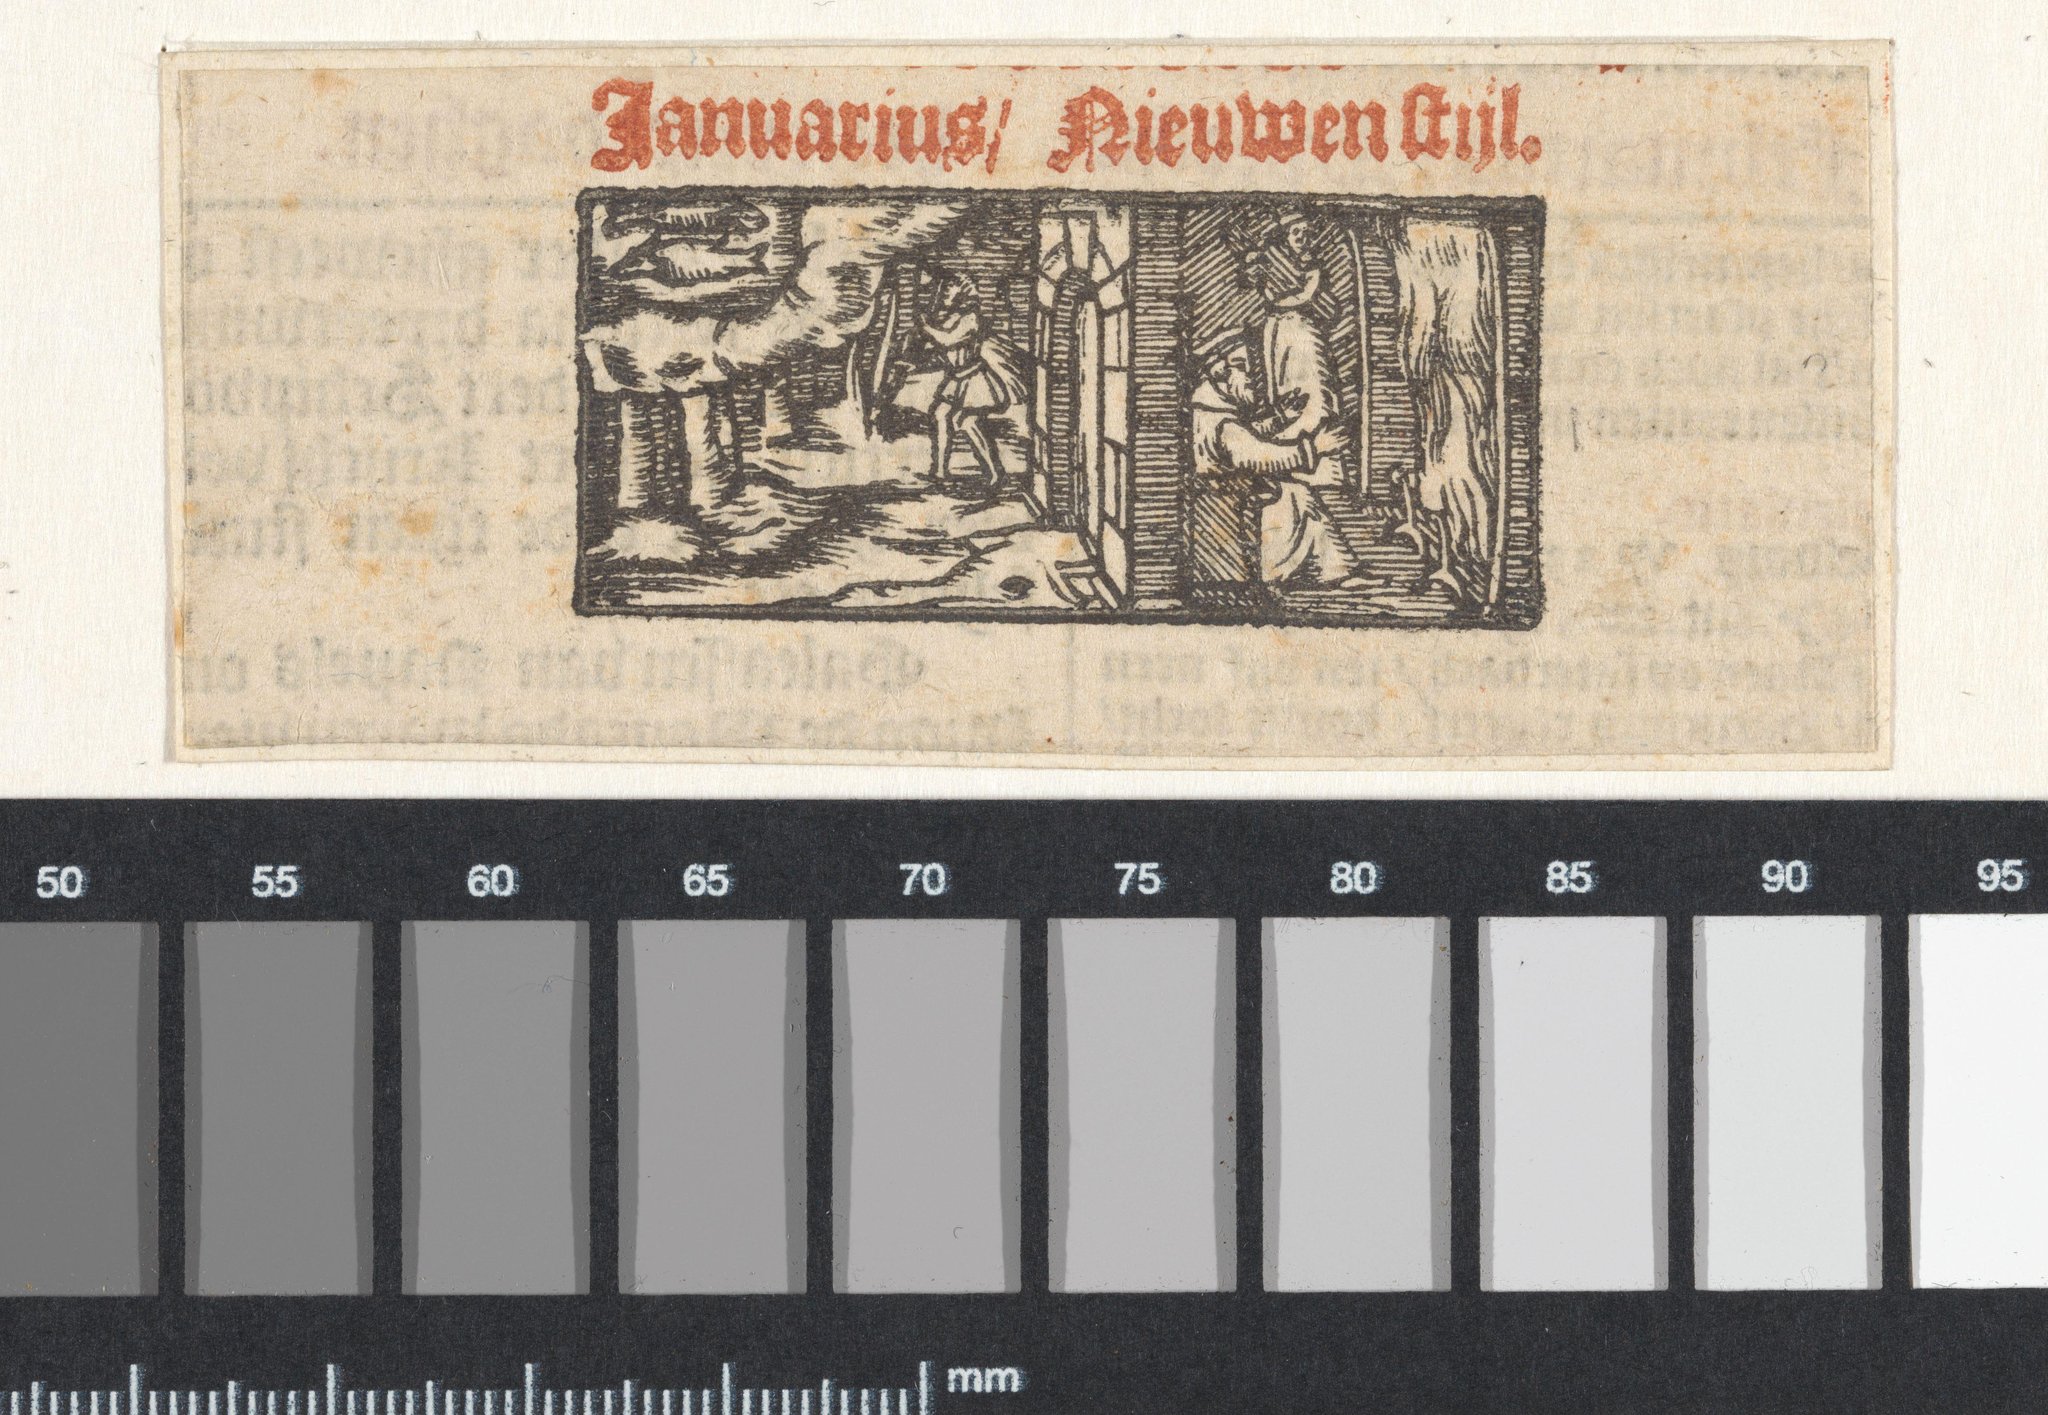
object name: print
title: Maanden van het jaar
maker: Anonymous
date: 1600-1699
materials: paper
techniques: letterpress printing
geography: netherlands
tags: open hearth, fire-place, snow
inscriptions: collector's mark: Lugt 240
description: Een man buiten lopend door de sneeuw en twee figuren zich binnen warmend bij een haard. Linksboven twee vissen.